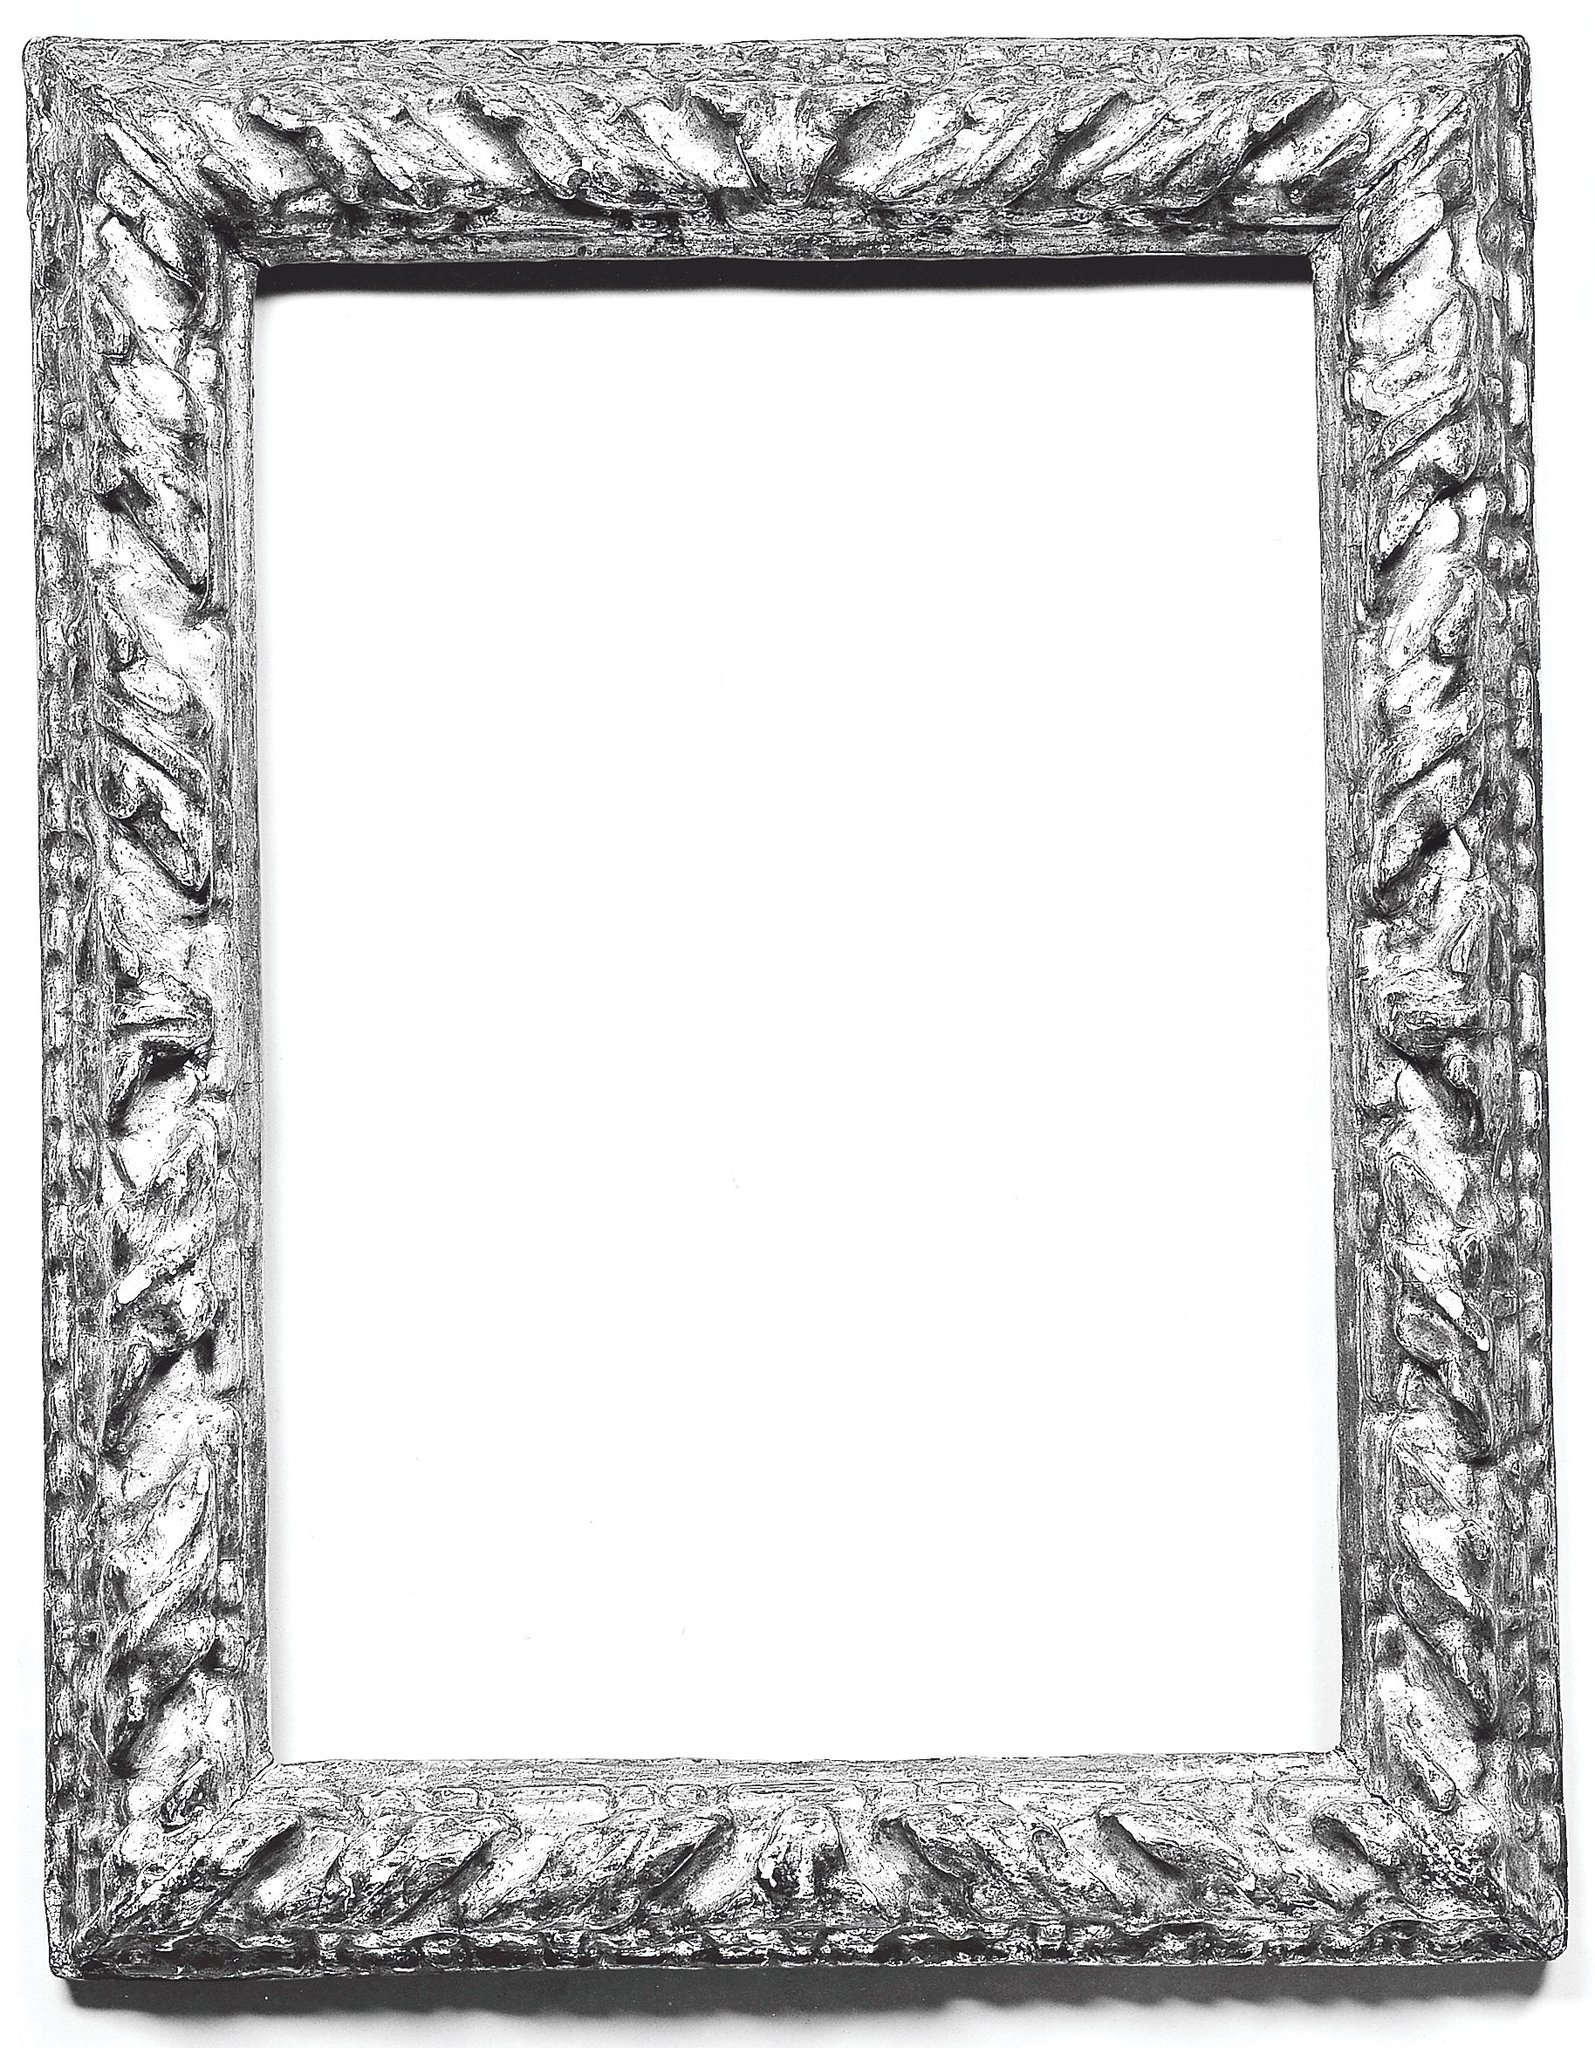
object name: frame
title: Astragal frame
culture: italian, veneto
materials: wood